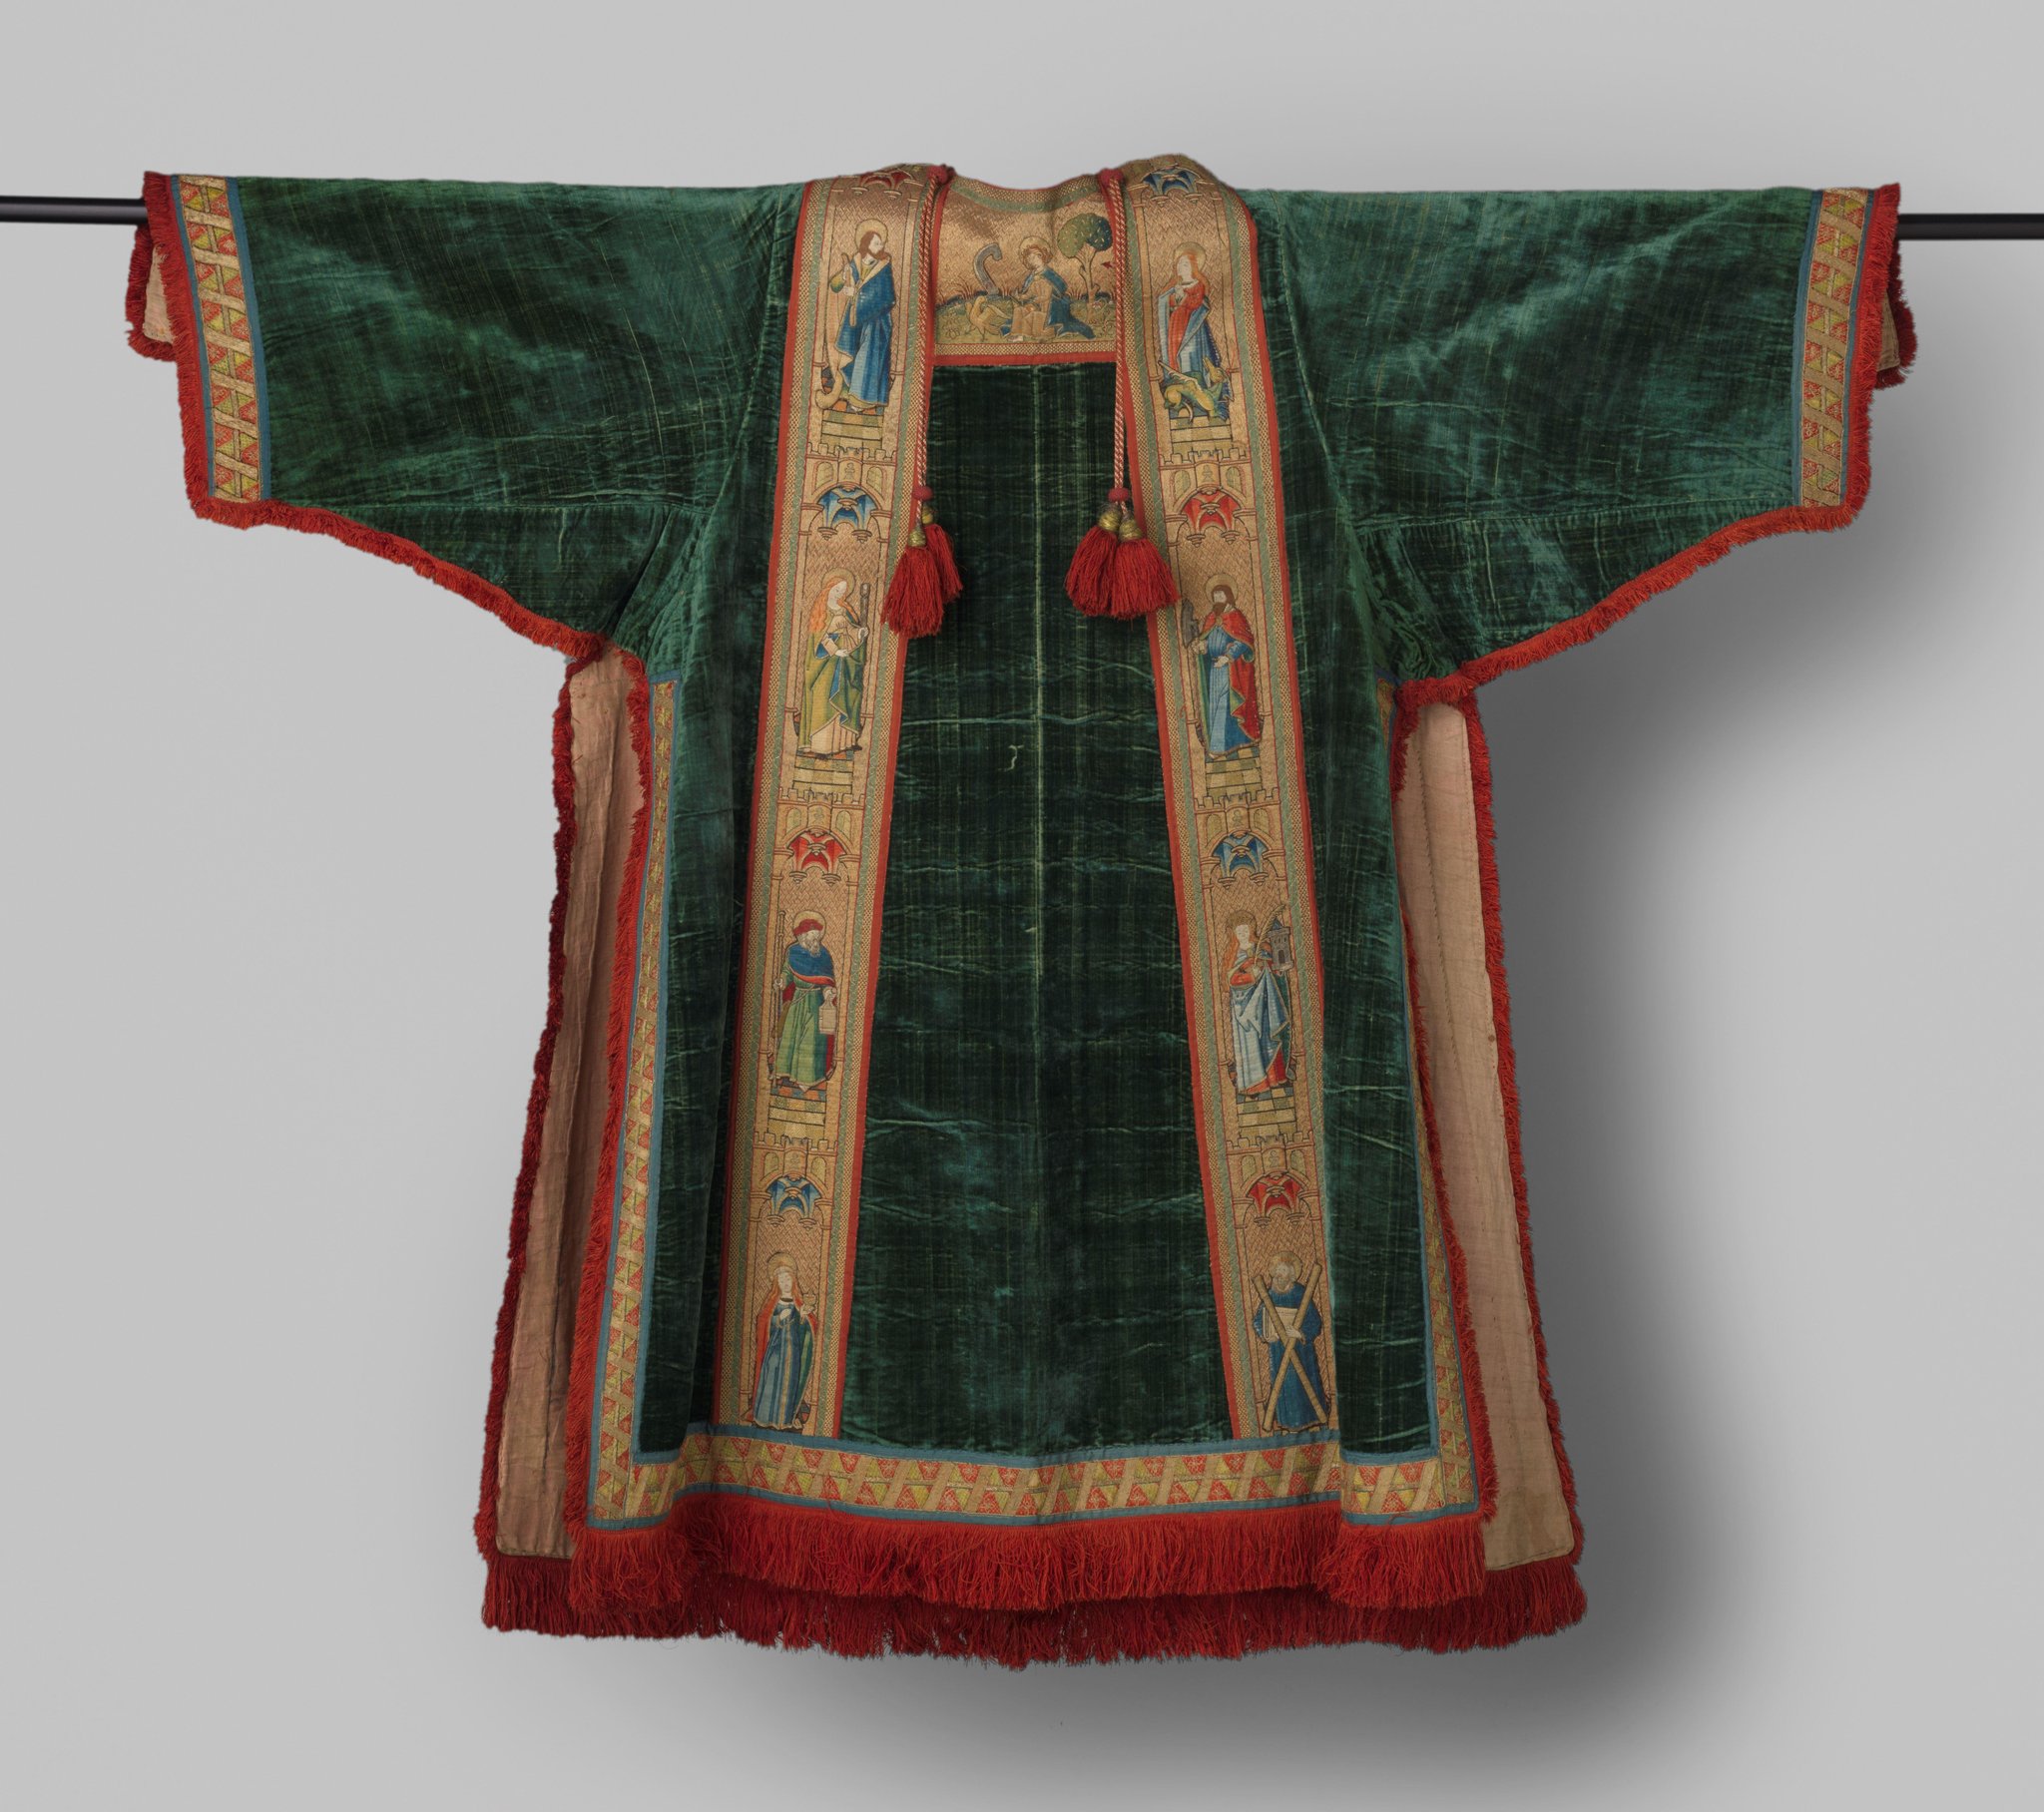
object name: dalmatic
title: Dalmatiek van groen fluweel met borduurwerk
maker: Anonymous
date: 1500-1525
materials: gold thread, velvet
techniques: embroidered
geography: netherlands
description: Dalmatic with the Virgin and Child with St Anne, apostles, fathers of the church and saints. Velvet, silk, gold thread. Netherlands, c. 1500 - 1525